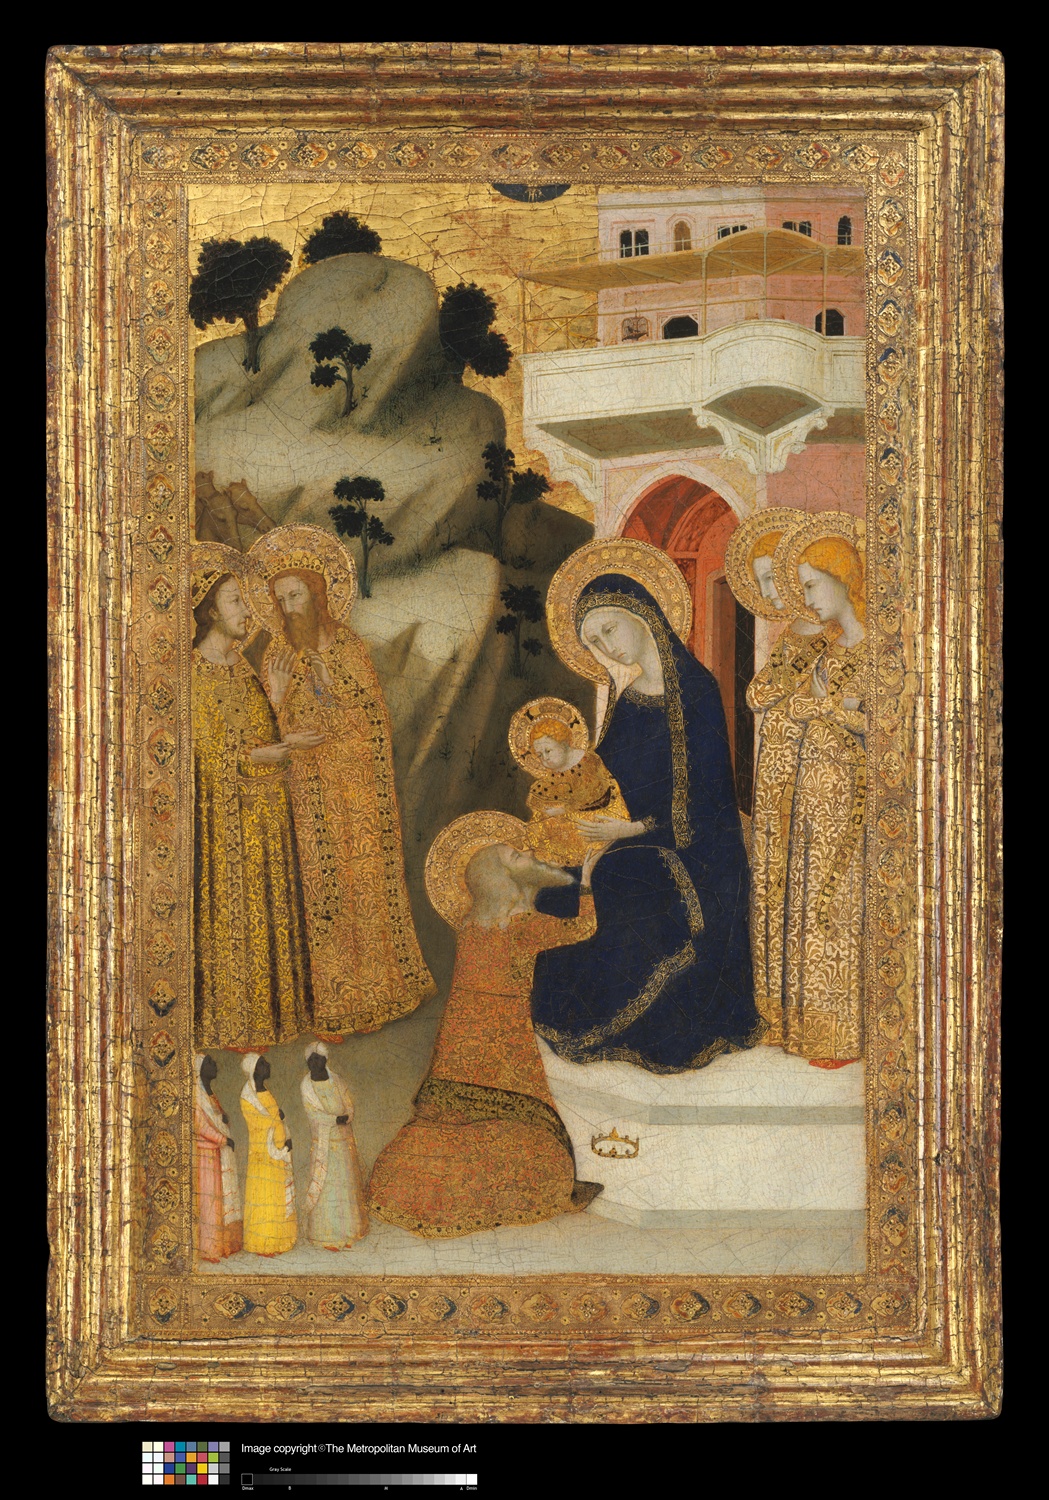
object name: frame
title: Panel from a polyptych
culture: italian, neapolitan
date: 1343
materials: gilt, wood